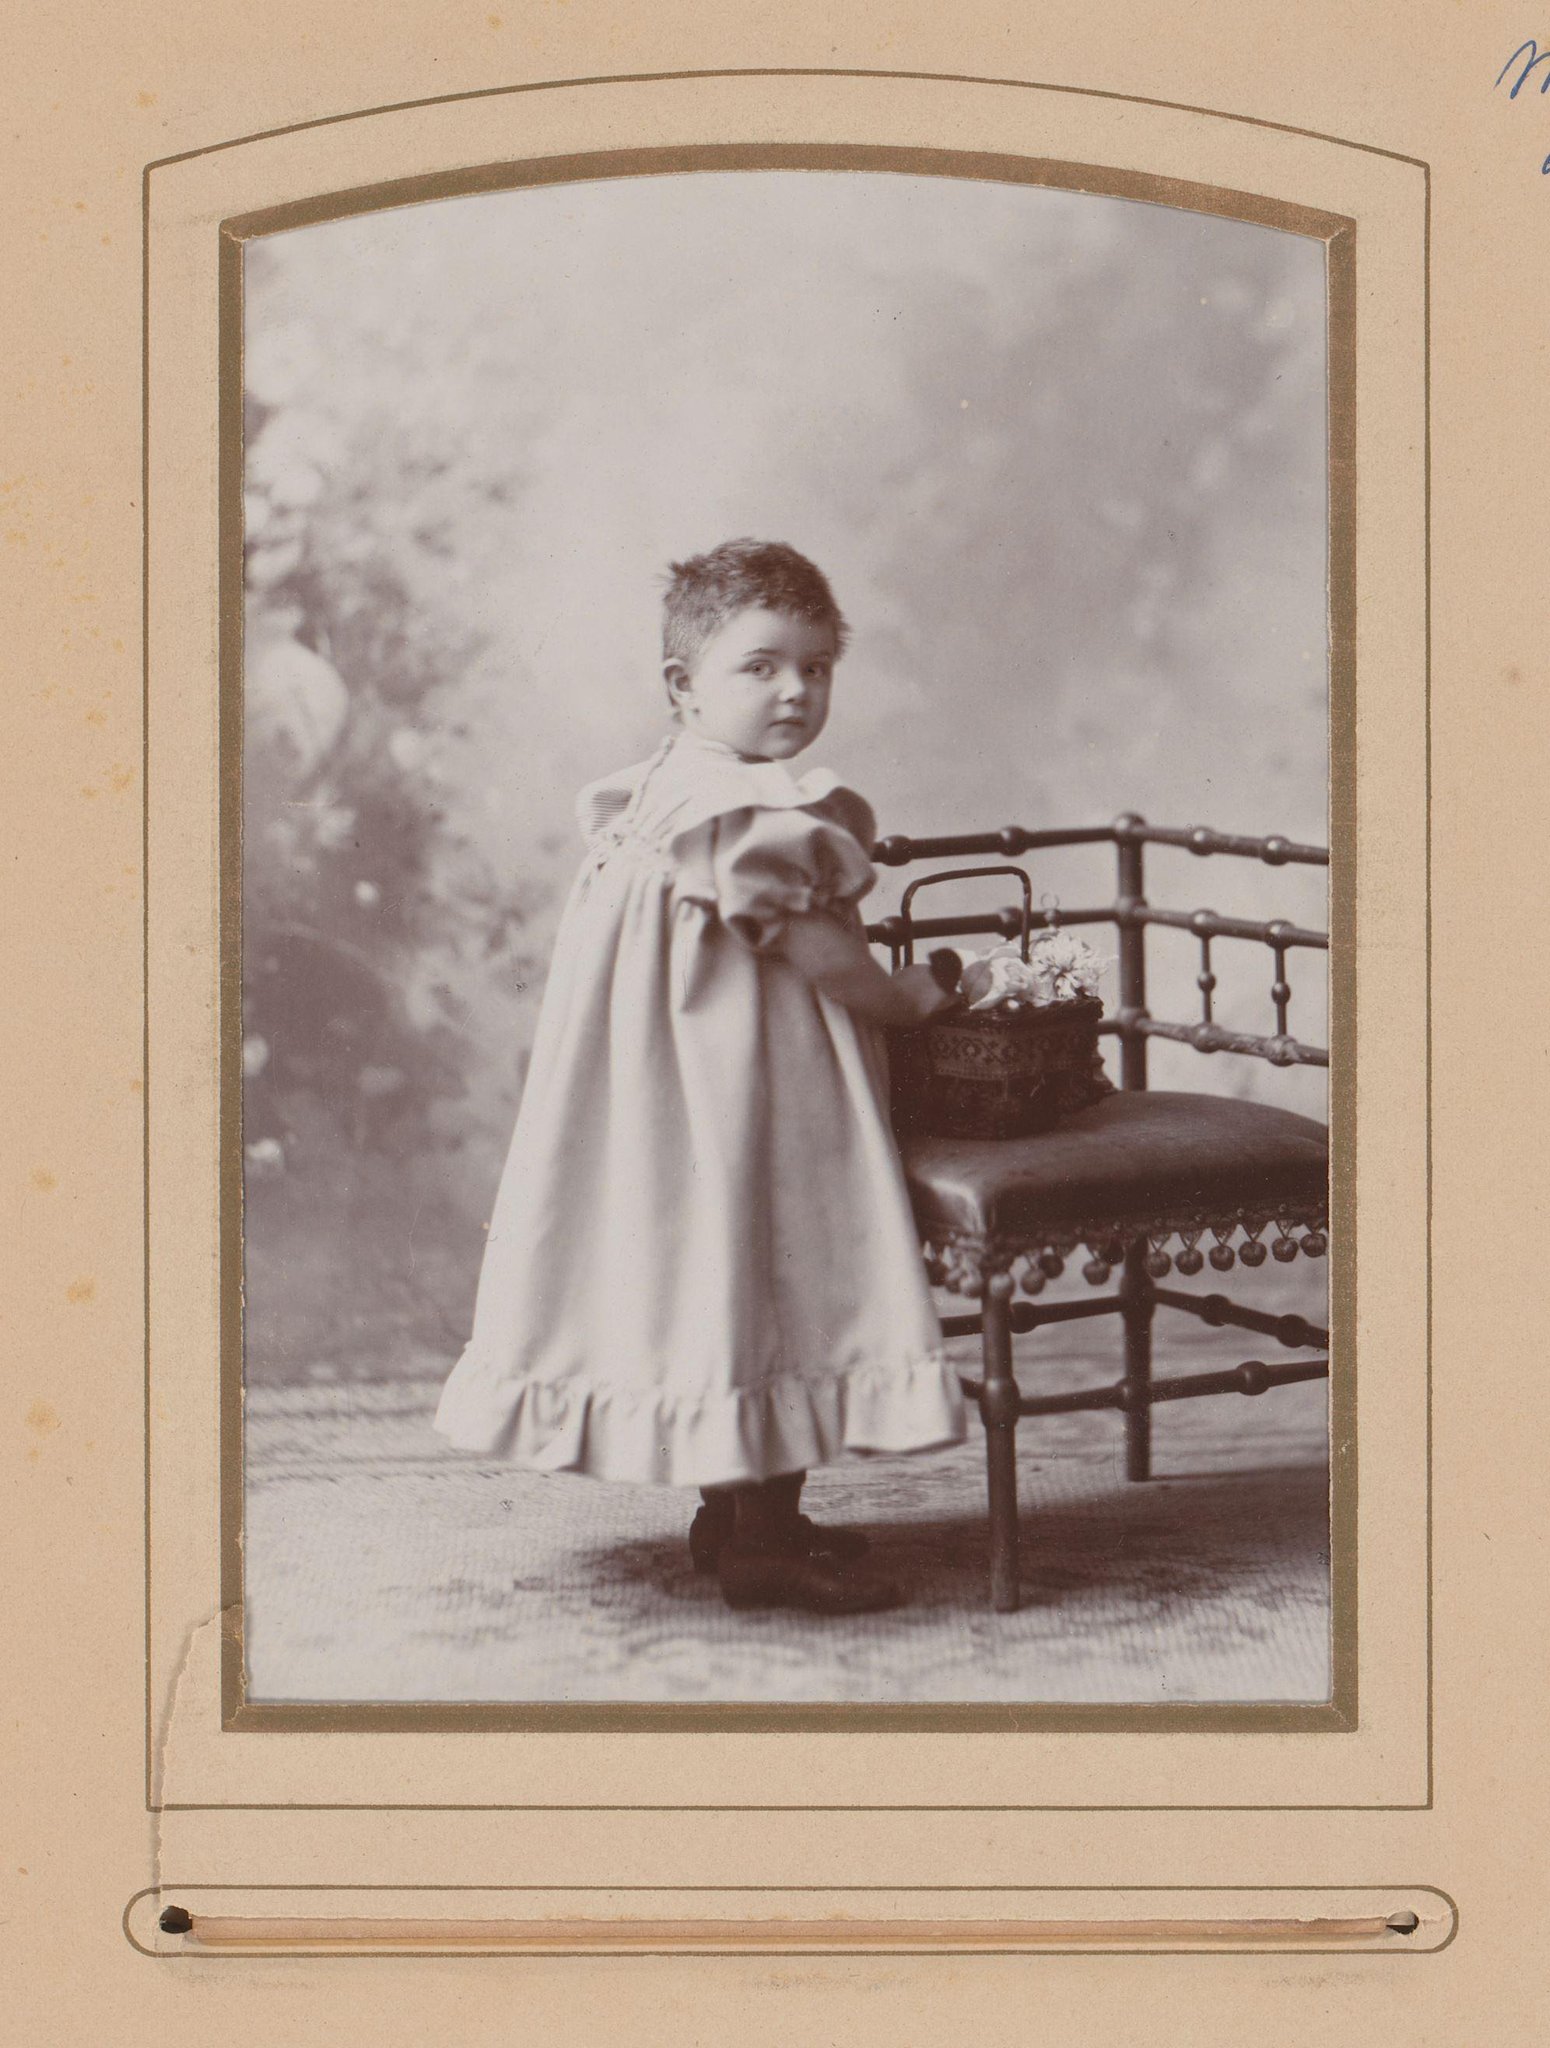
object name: photograph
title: Portret van Tootje Roos als peuter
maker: albert greiner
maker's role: fotograaf, fotostudio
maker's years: 1833-1890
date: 1883-1887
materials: cardboard, photographic support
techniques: collodion silver print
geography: amsterdam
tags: historical persons - bb - woman, toddler (female)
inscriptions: annotation: ‘Tootje Roos,/ moeder hield van lang/ met het/ oog op/ de groei!’, inscription: ‘Albert Greiner/ Photograaf van wijlen Z.M. den Koning Willem III/ en van H.M. de Koningin Weduwe/ BEKROOND/ te/ Paris 1878./ Amsterdam 1877./ Arnhem 1879./ Amsterdam 1883./ Amsterdam/ Nieuwendijk No. 89./ SPECIALITEIT IN VERGROOTINGEN.’, number: ‘6481B’